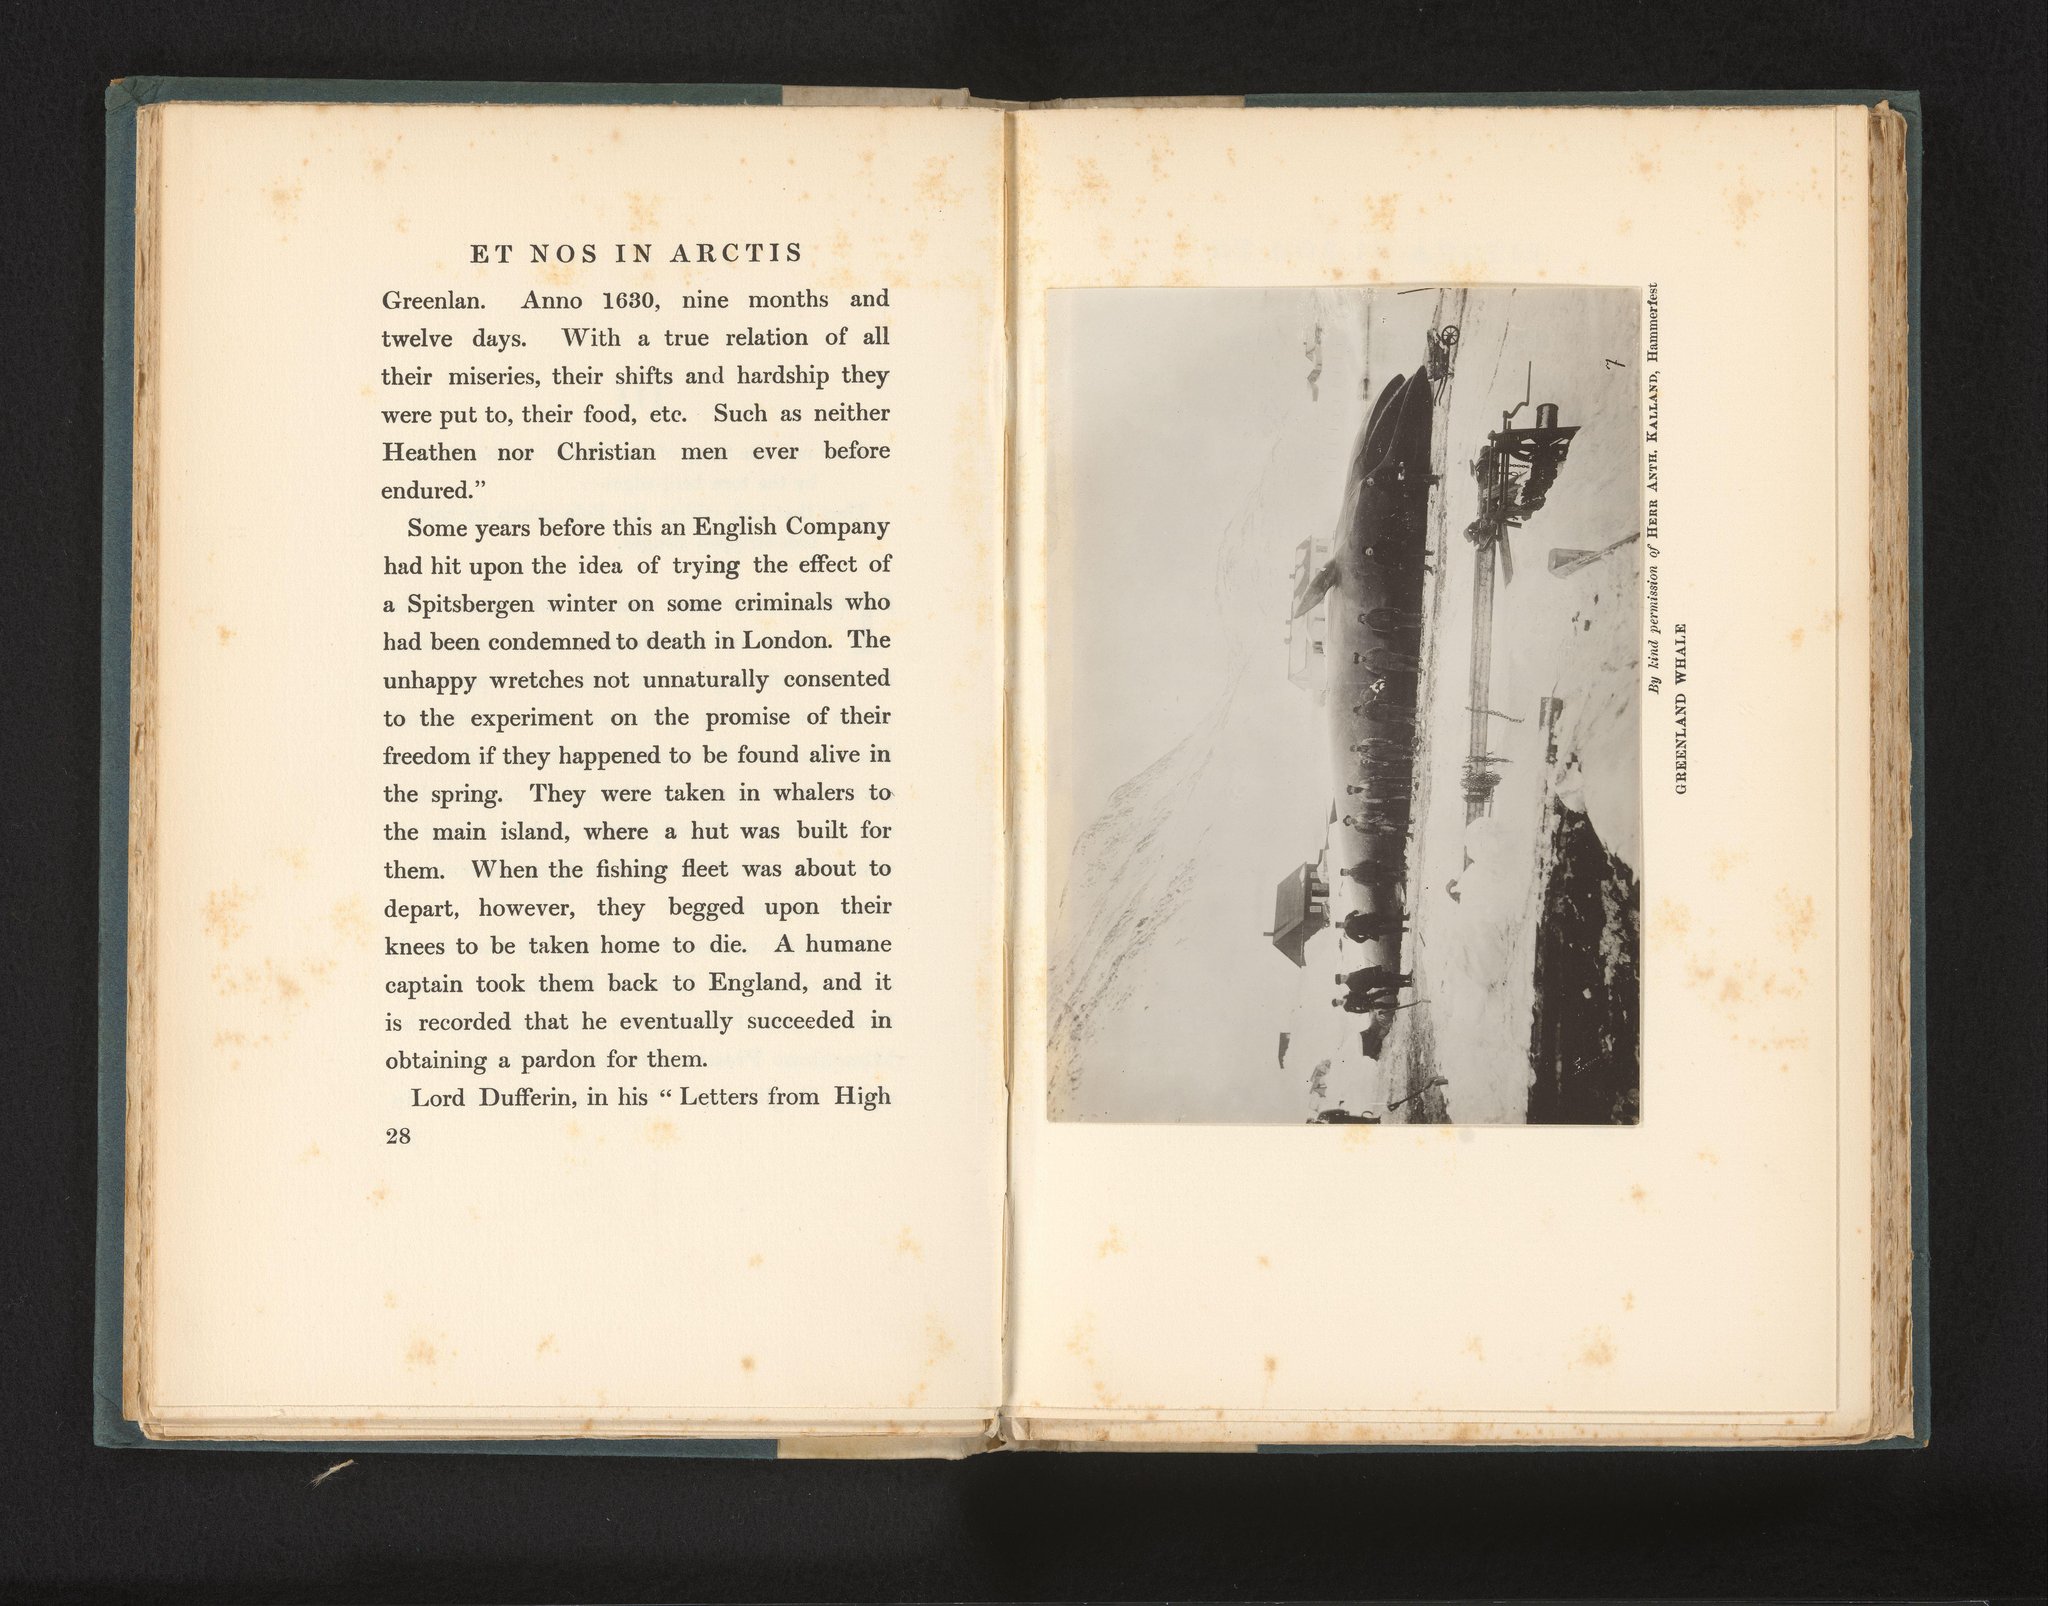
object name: photograph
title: Walvisjagers voor het lichaam van een Groenlandse walvis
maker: anthon kalland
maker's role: painter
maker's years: 1856-1933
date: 1908-1913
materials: paper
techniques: gelatin silver print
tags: whale fishery, whaling, greenland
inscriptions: inscription: ‘By kind permission of HERR ANTH. KALLAND, Hammerfest’